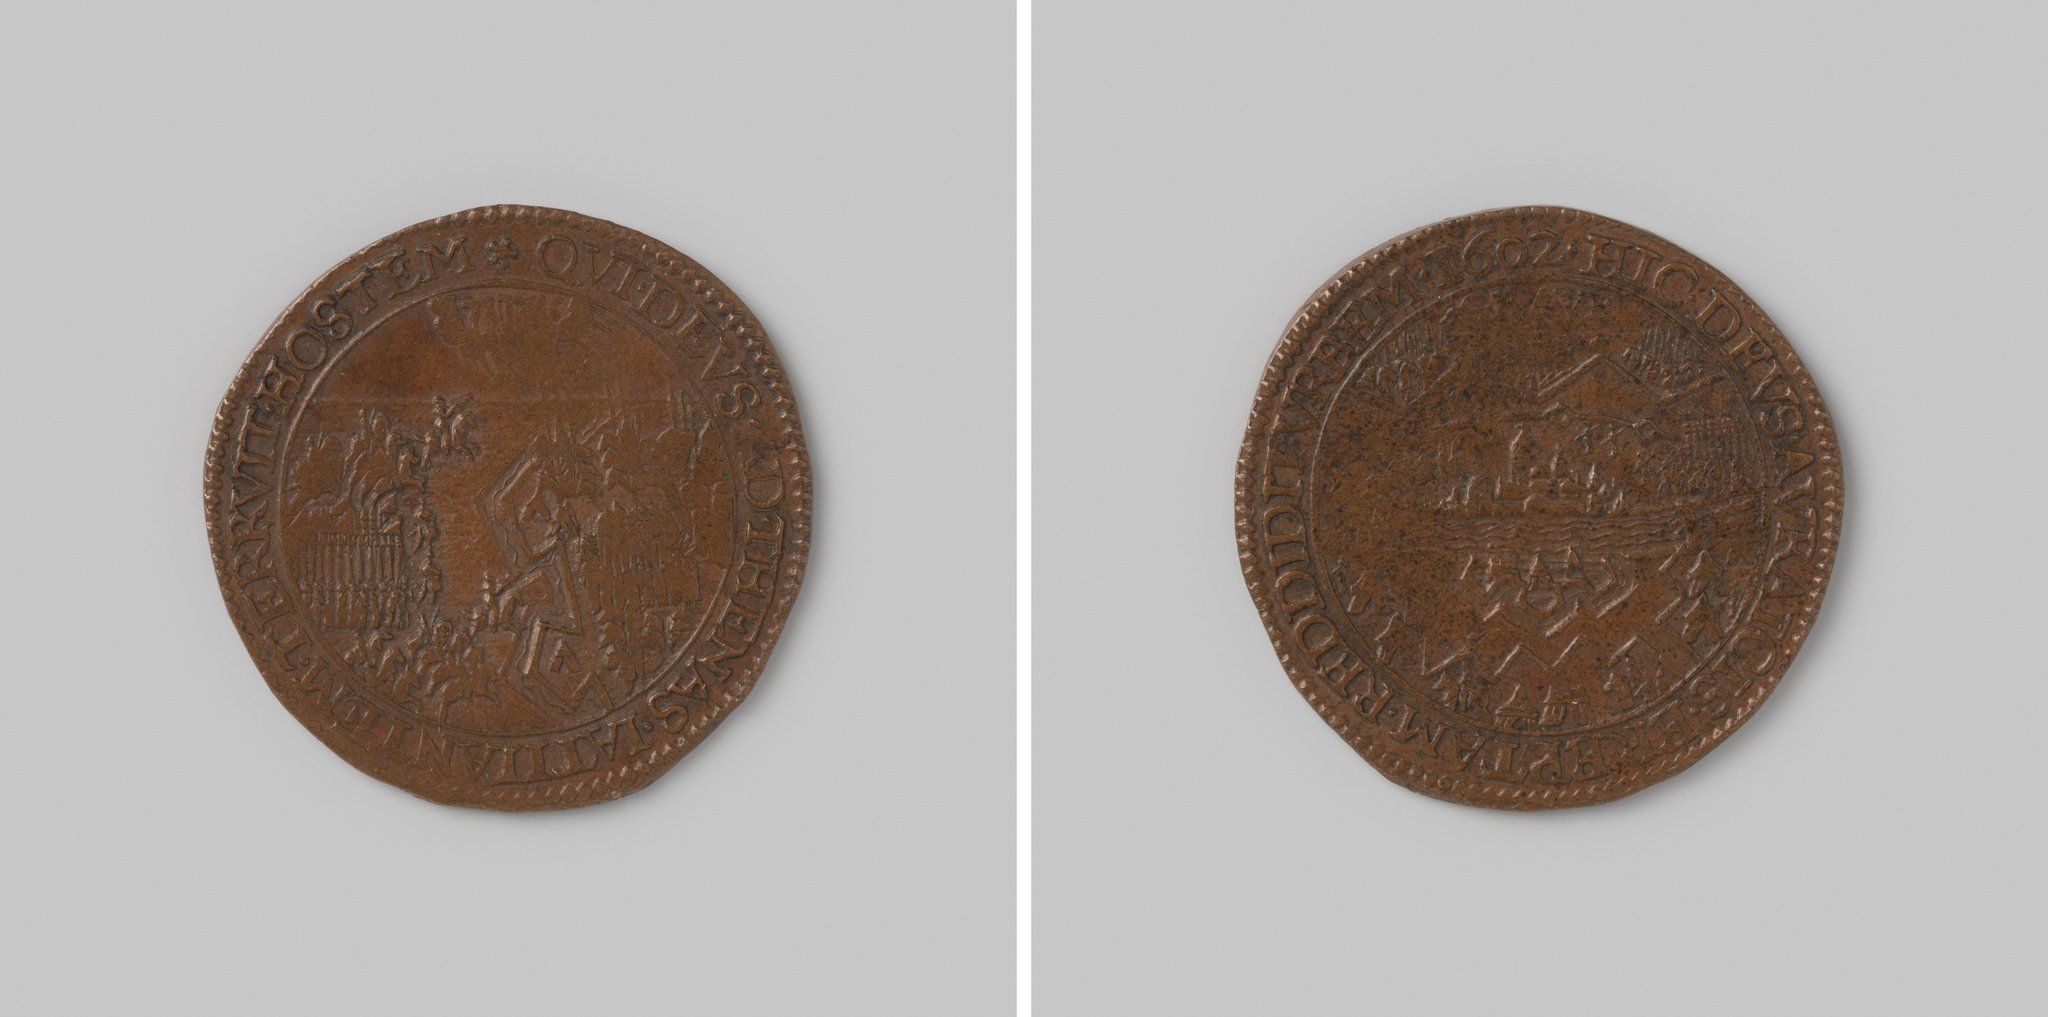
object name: history medal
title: Rekenpenning uit Dordrecht op de overgave van Grave 1602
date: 1602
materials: copper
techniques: striking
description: Koperen penning, op de voorzijde de stad Tienen met Mendoza's leger in vogelvlucht, met omschrift, op de keerzijde de plattegrond van Grave met legerkampen en soldaten, met omschrift.